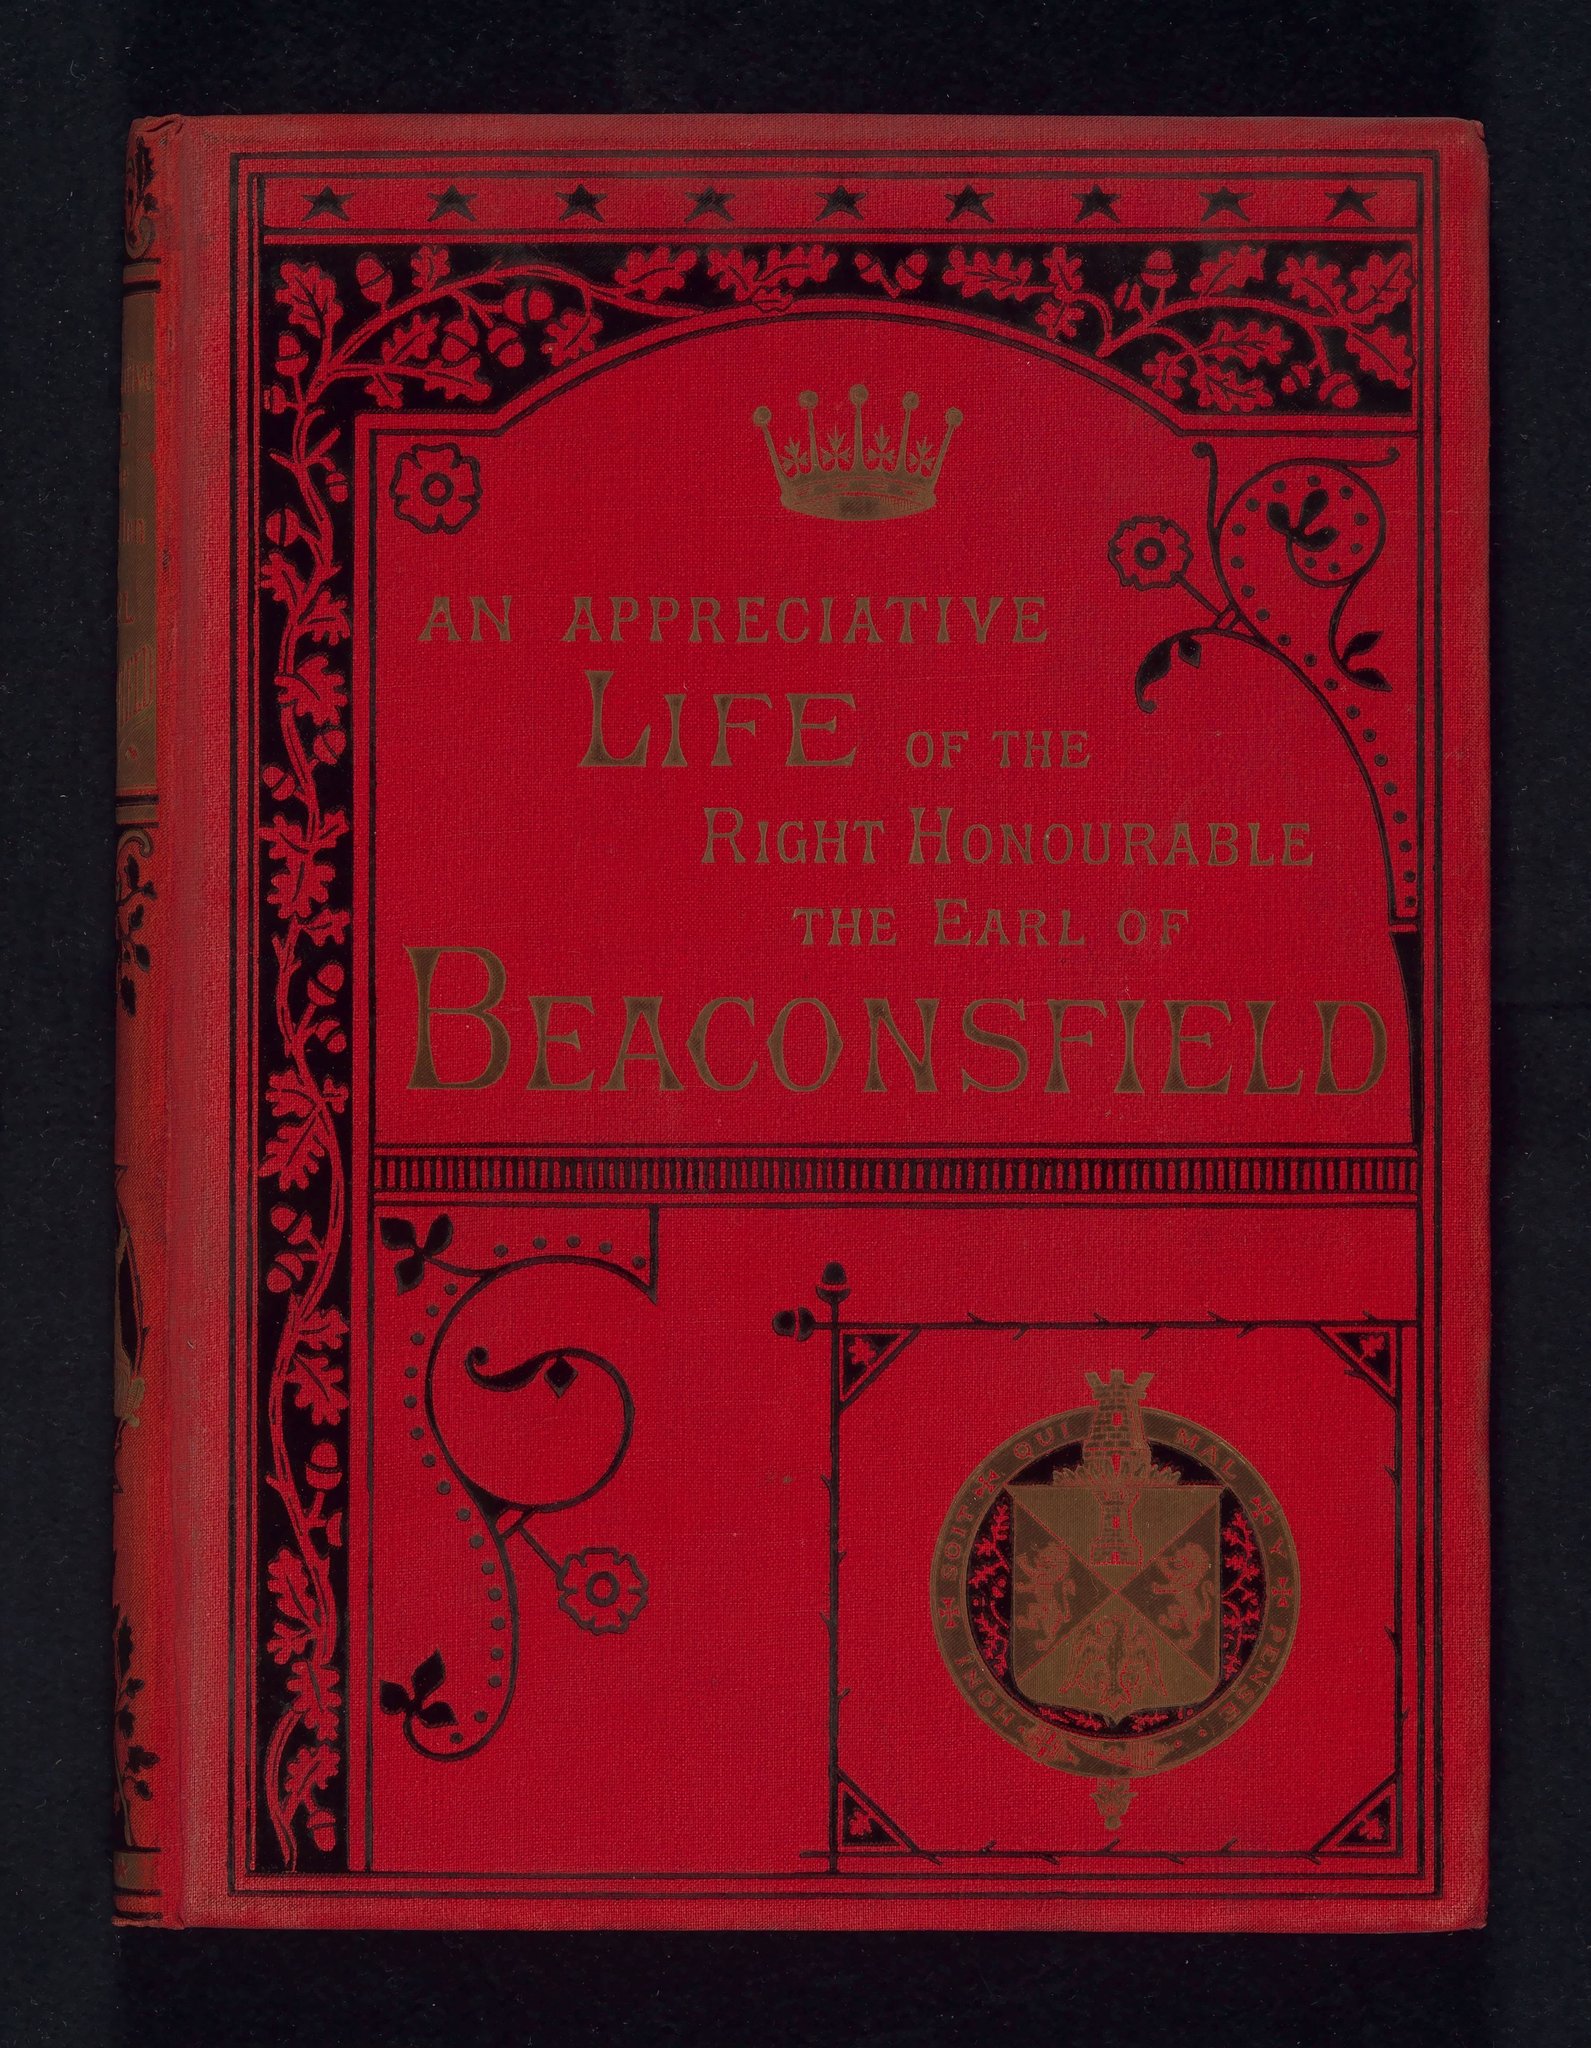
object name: book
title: An appreciative life of the Right. Hon. Earl of Beaconsfield, a statesman of Light and Leading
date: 1881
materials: cardboard, linen, paper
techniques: printing, woodburytype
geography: nottingham